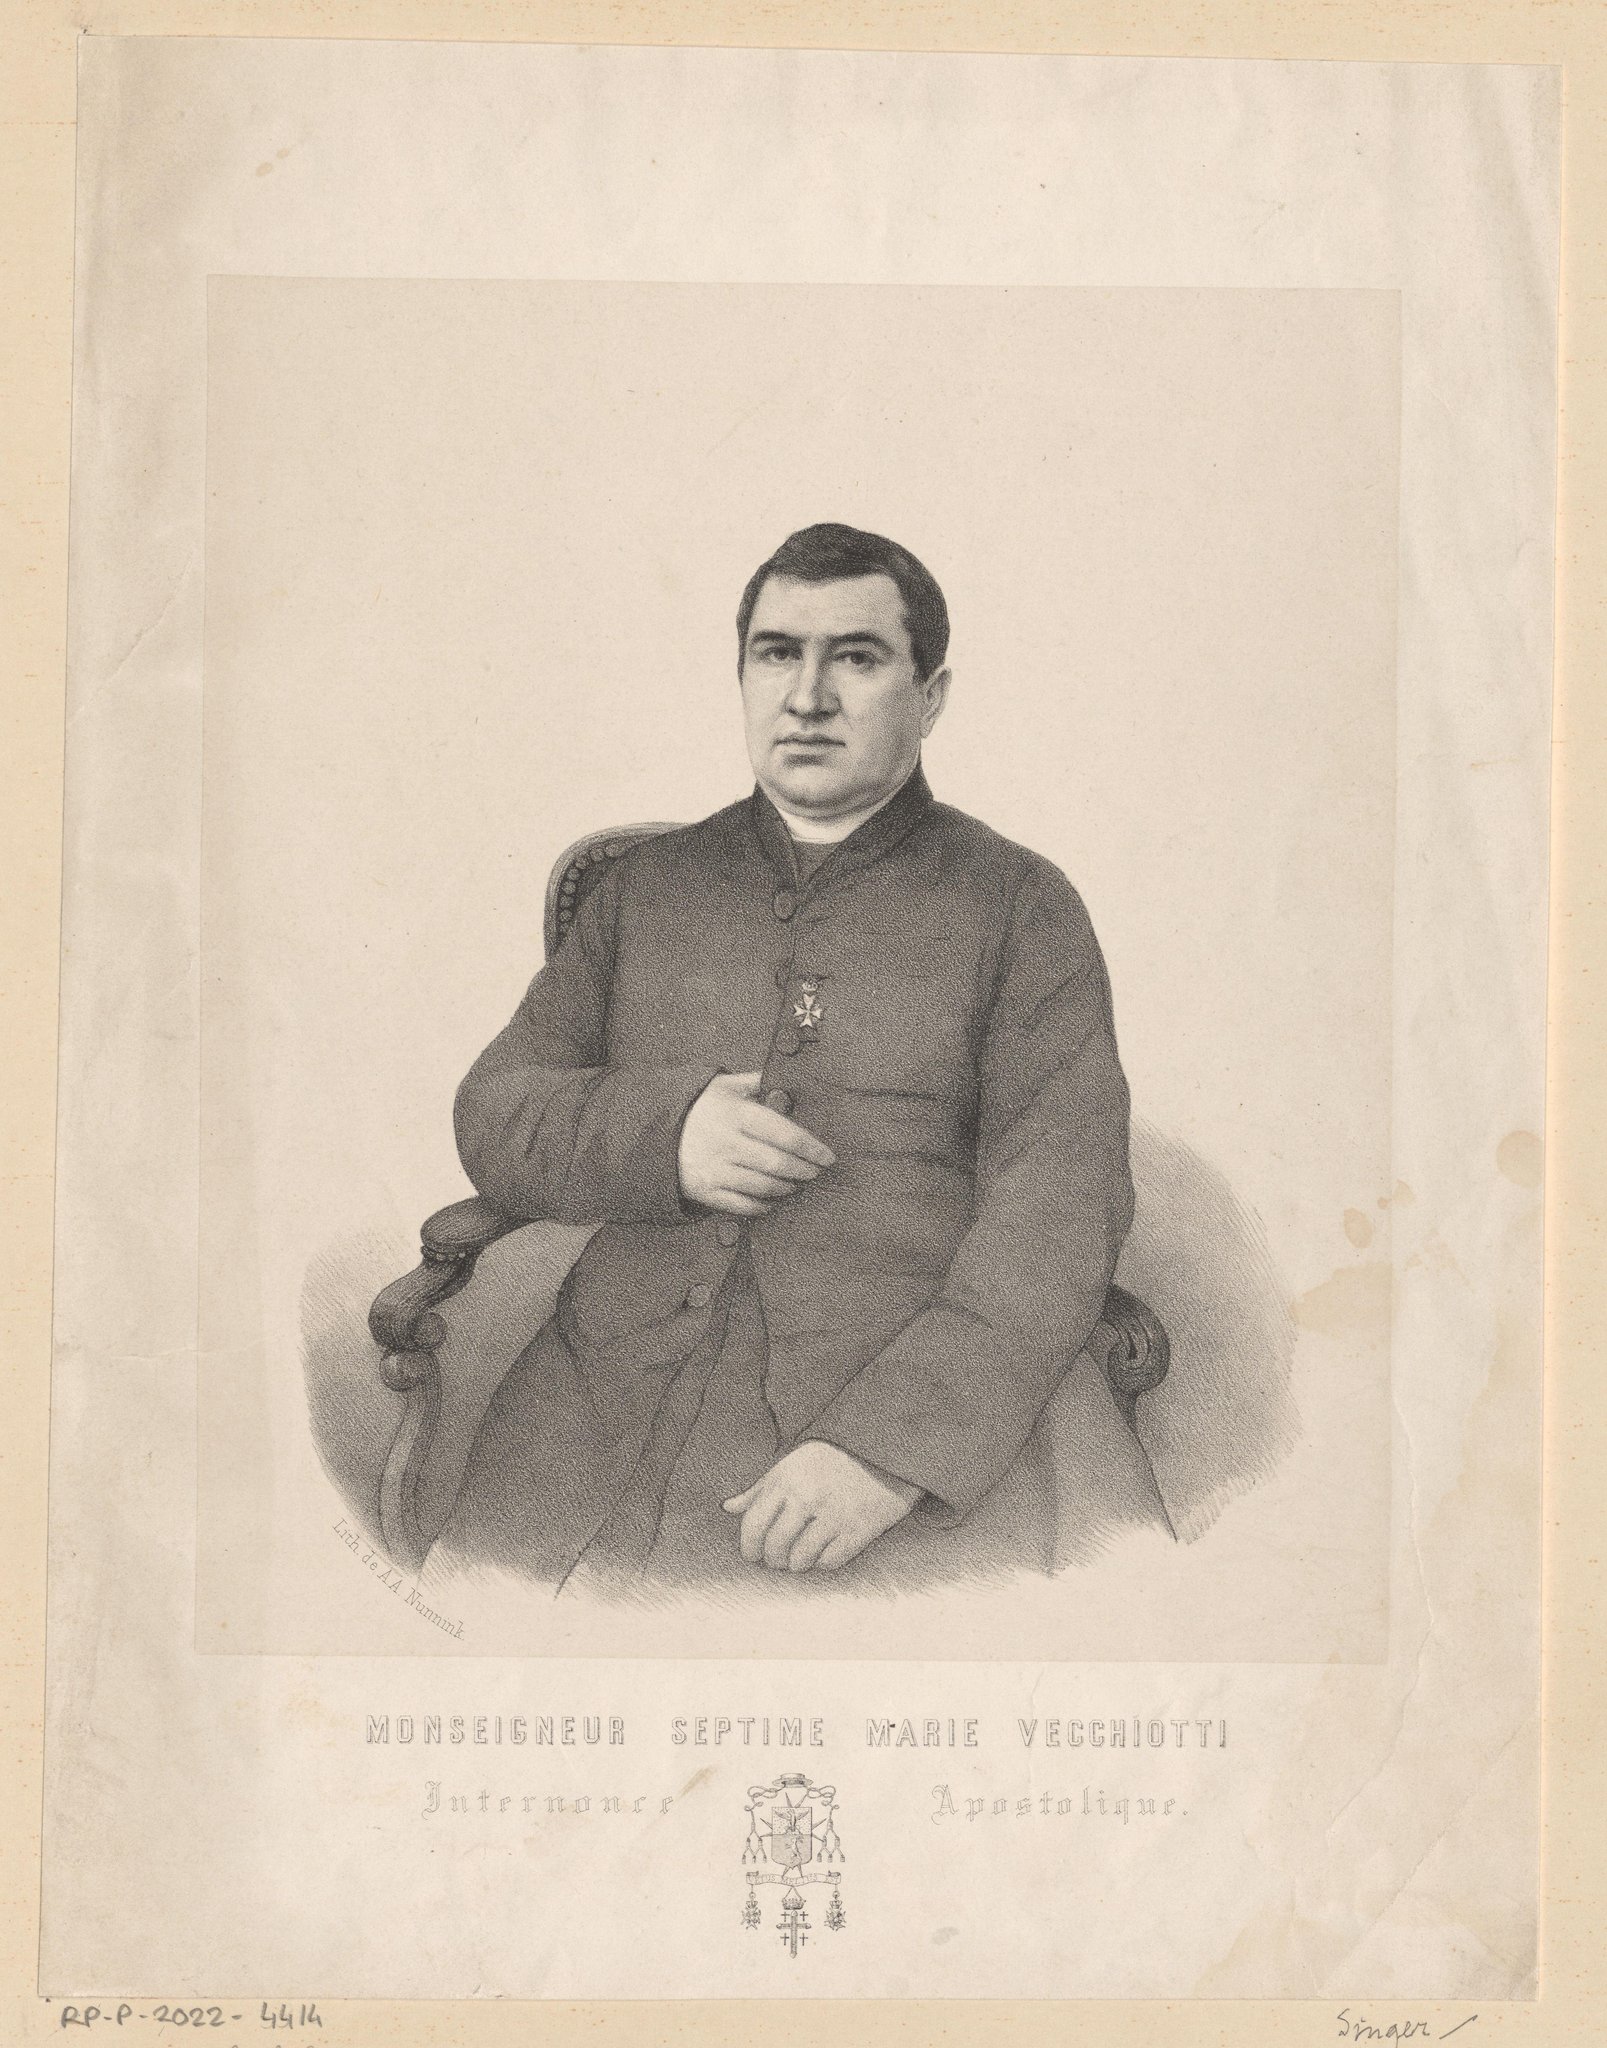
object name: print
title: Portret van Septime Marie Vecchiotti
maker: albertus anthonius nunnink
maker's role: print maker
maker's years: 1816-1895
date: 1855-1895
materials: paper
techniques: lithograph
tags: clergyman, historical persons, diplomacy, diplomat, organization, functionaries and dignitaries in roman catholic church; clergy in general